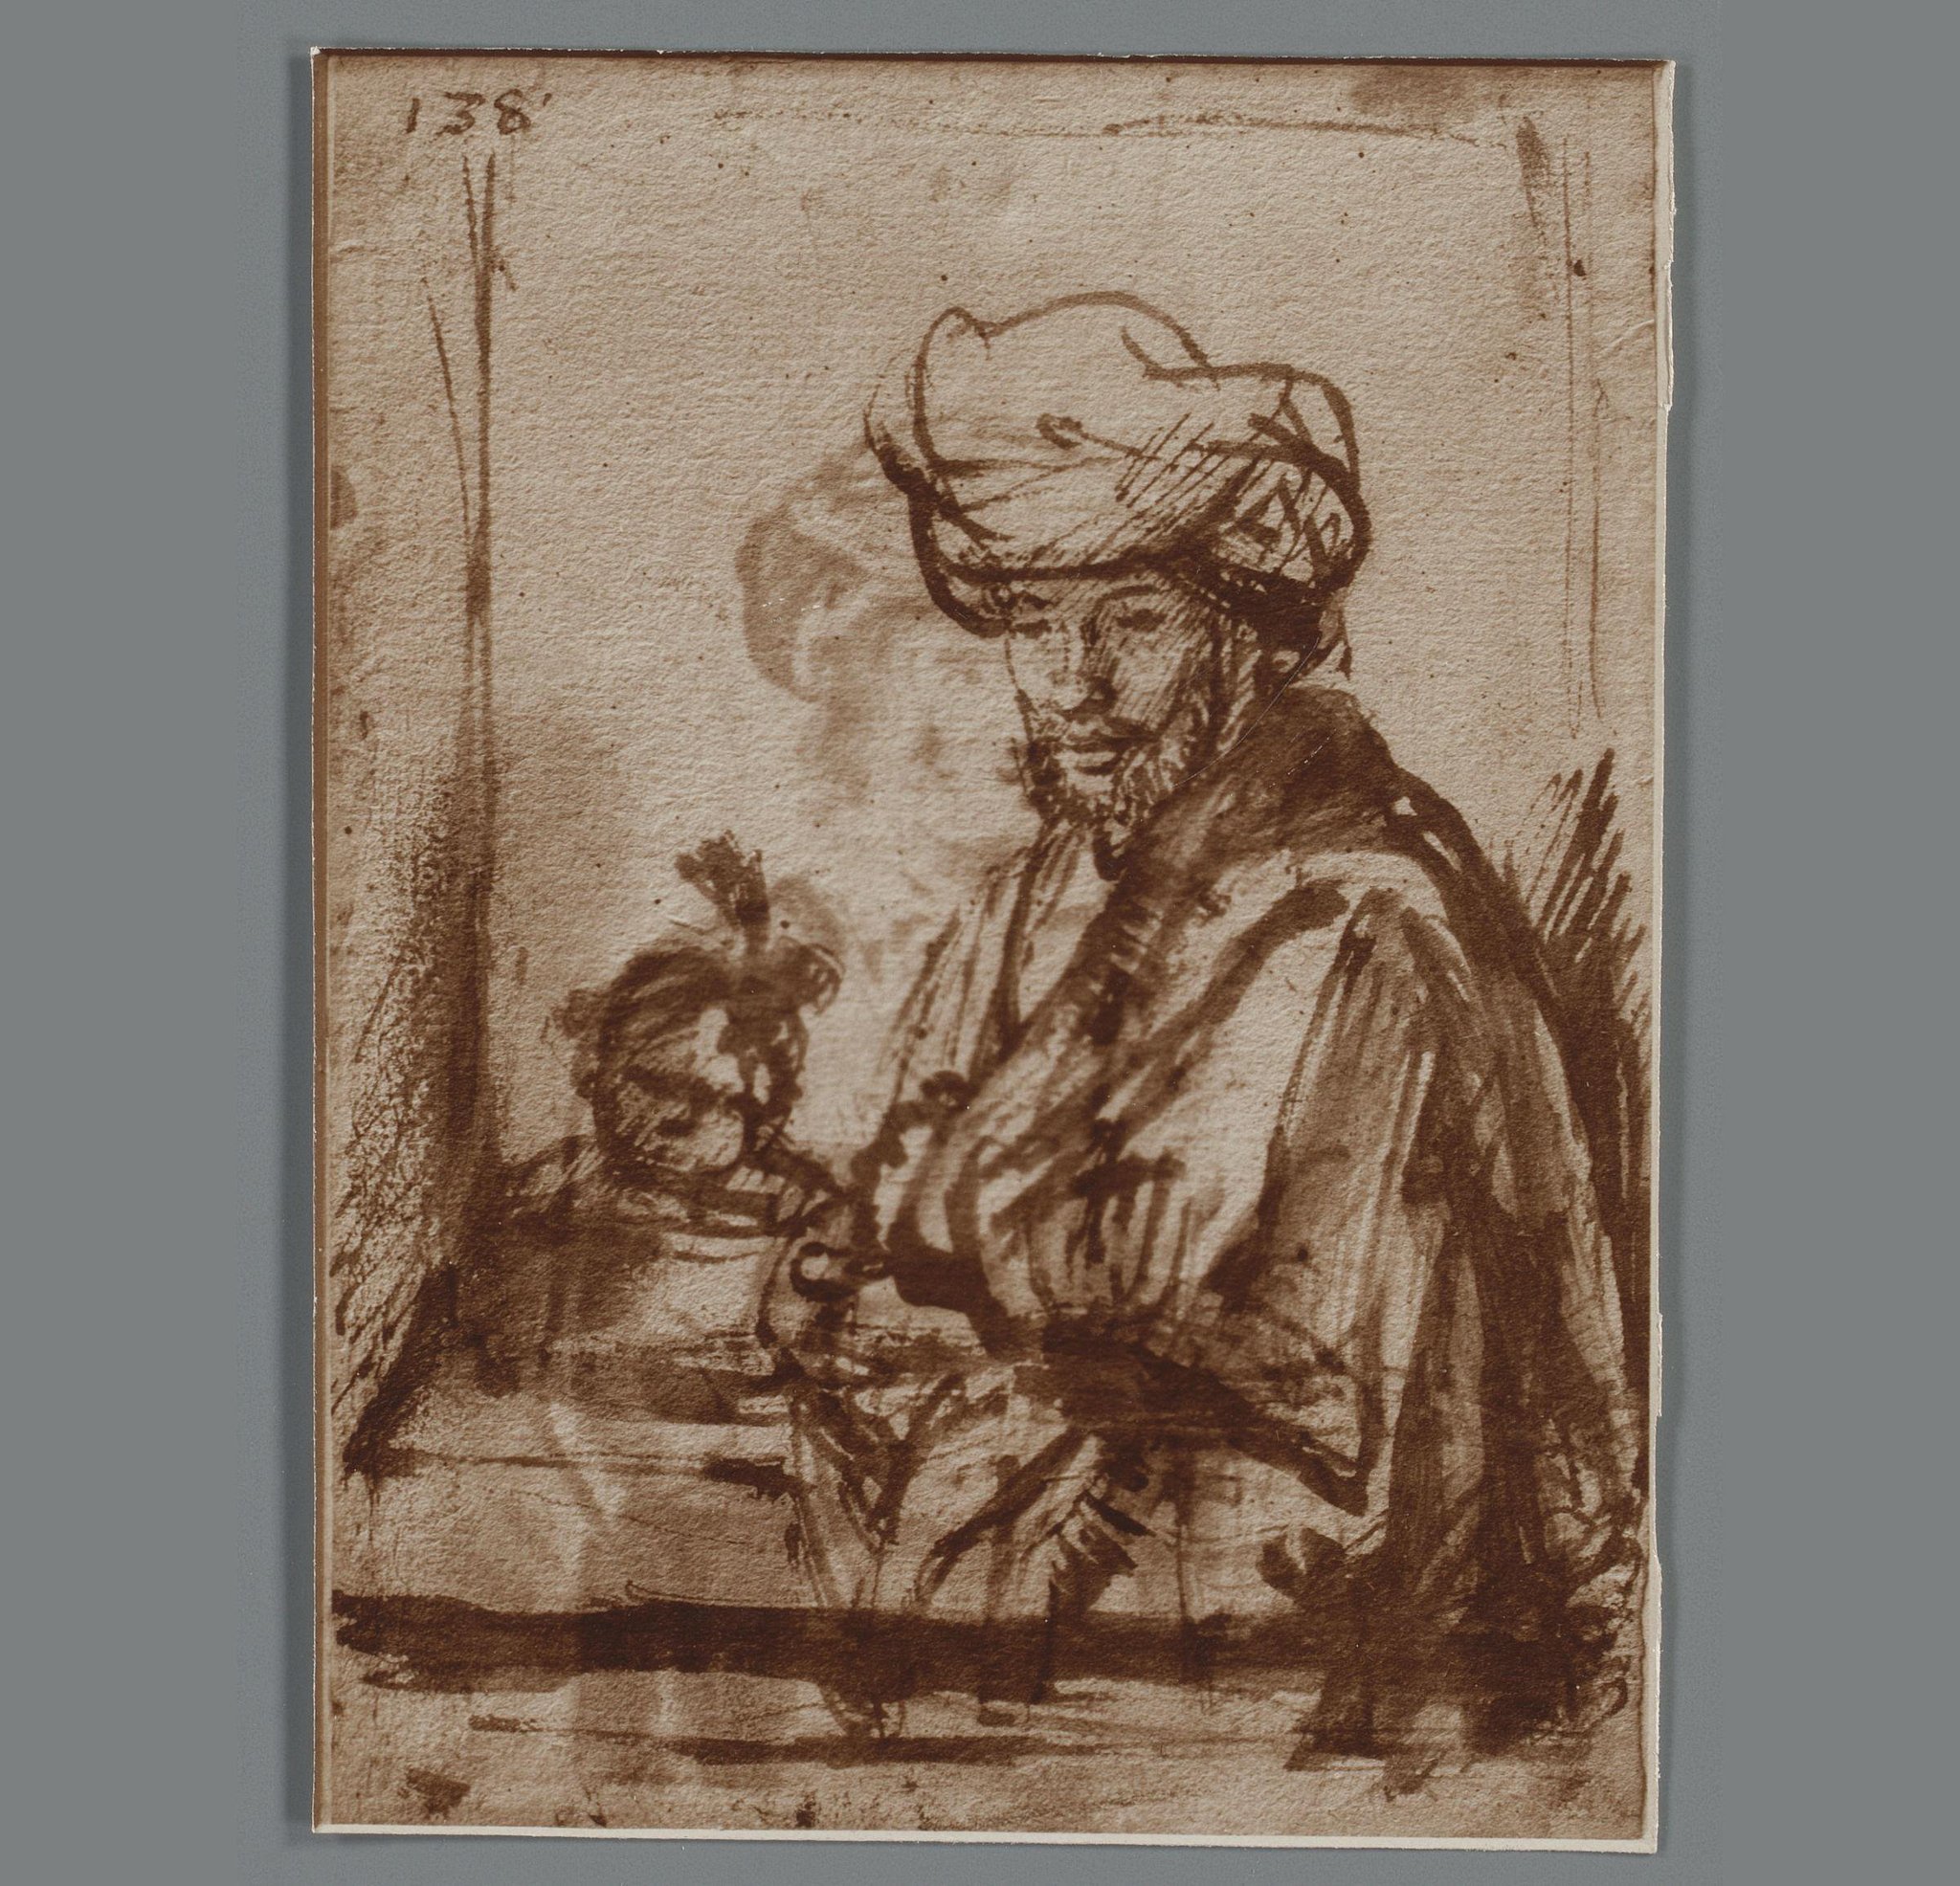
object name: photograph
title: Fotoreproductie van tekening van man met tulband, door Rembrandt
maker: Anonymous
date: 1880-1920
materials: paper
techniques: collodion silver print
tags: adult man, head-gear: turban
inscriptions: number: ‘607’, inscription: ‘Remrbandt./ tekening/ studie voor de pauwen/ Berlijn’